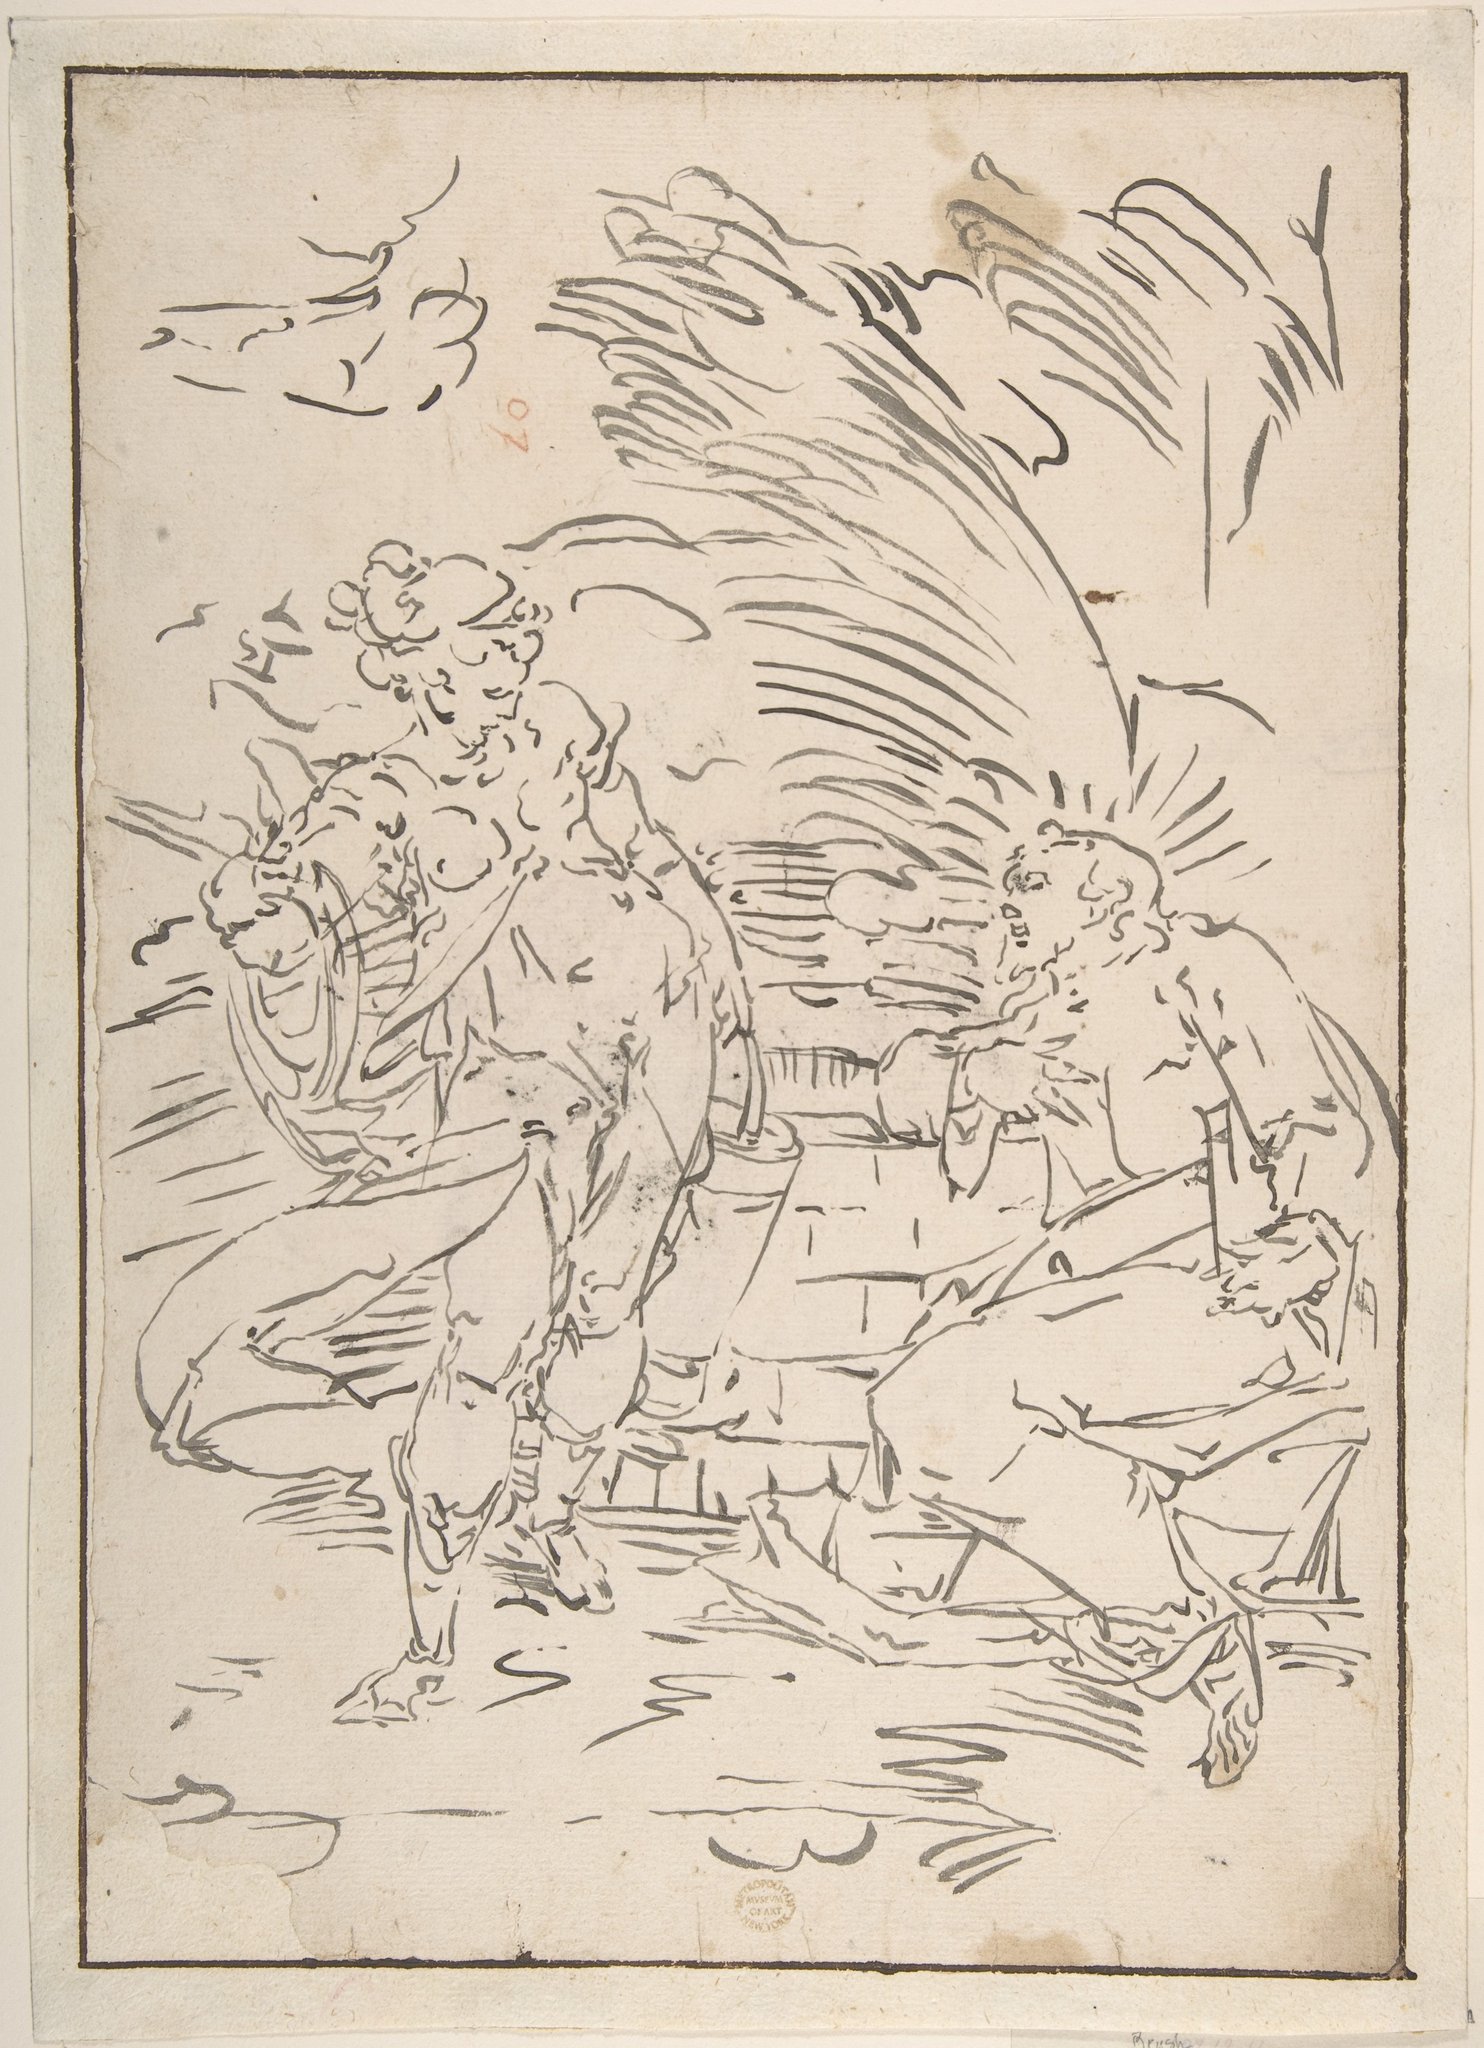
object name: drawing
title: Christ and the Woman of Samaria at the Well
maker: luca cambiaso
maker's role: artist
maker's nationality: italian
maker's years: 1527-1585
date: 1527-1585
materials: ink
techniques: brush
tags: wells,women,christ